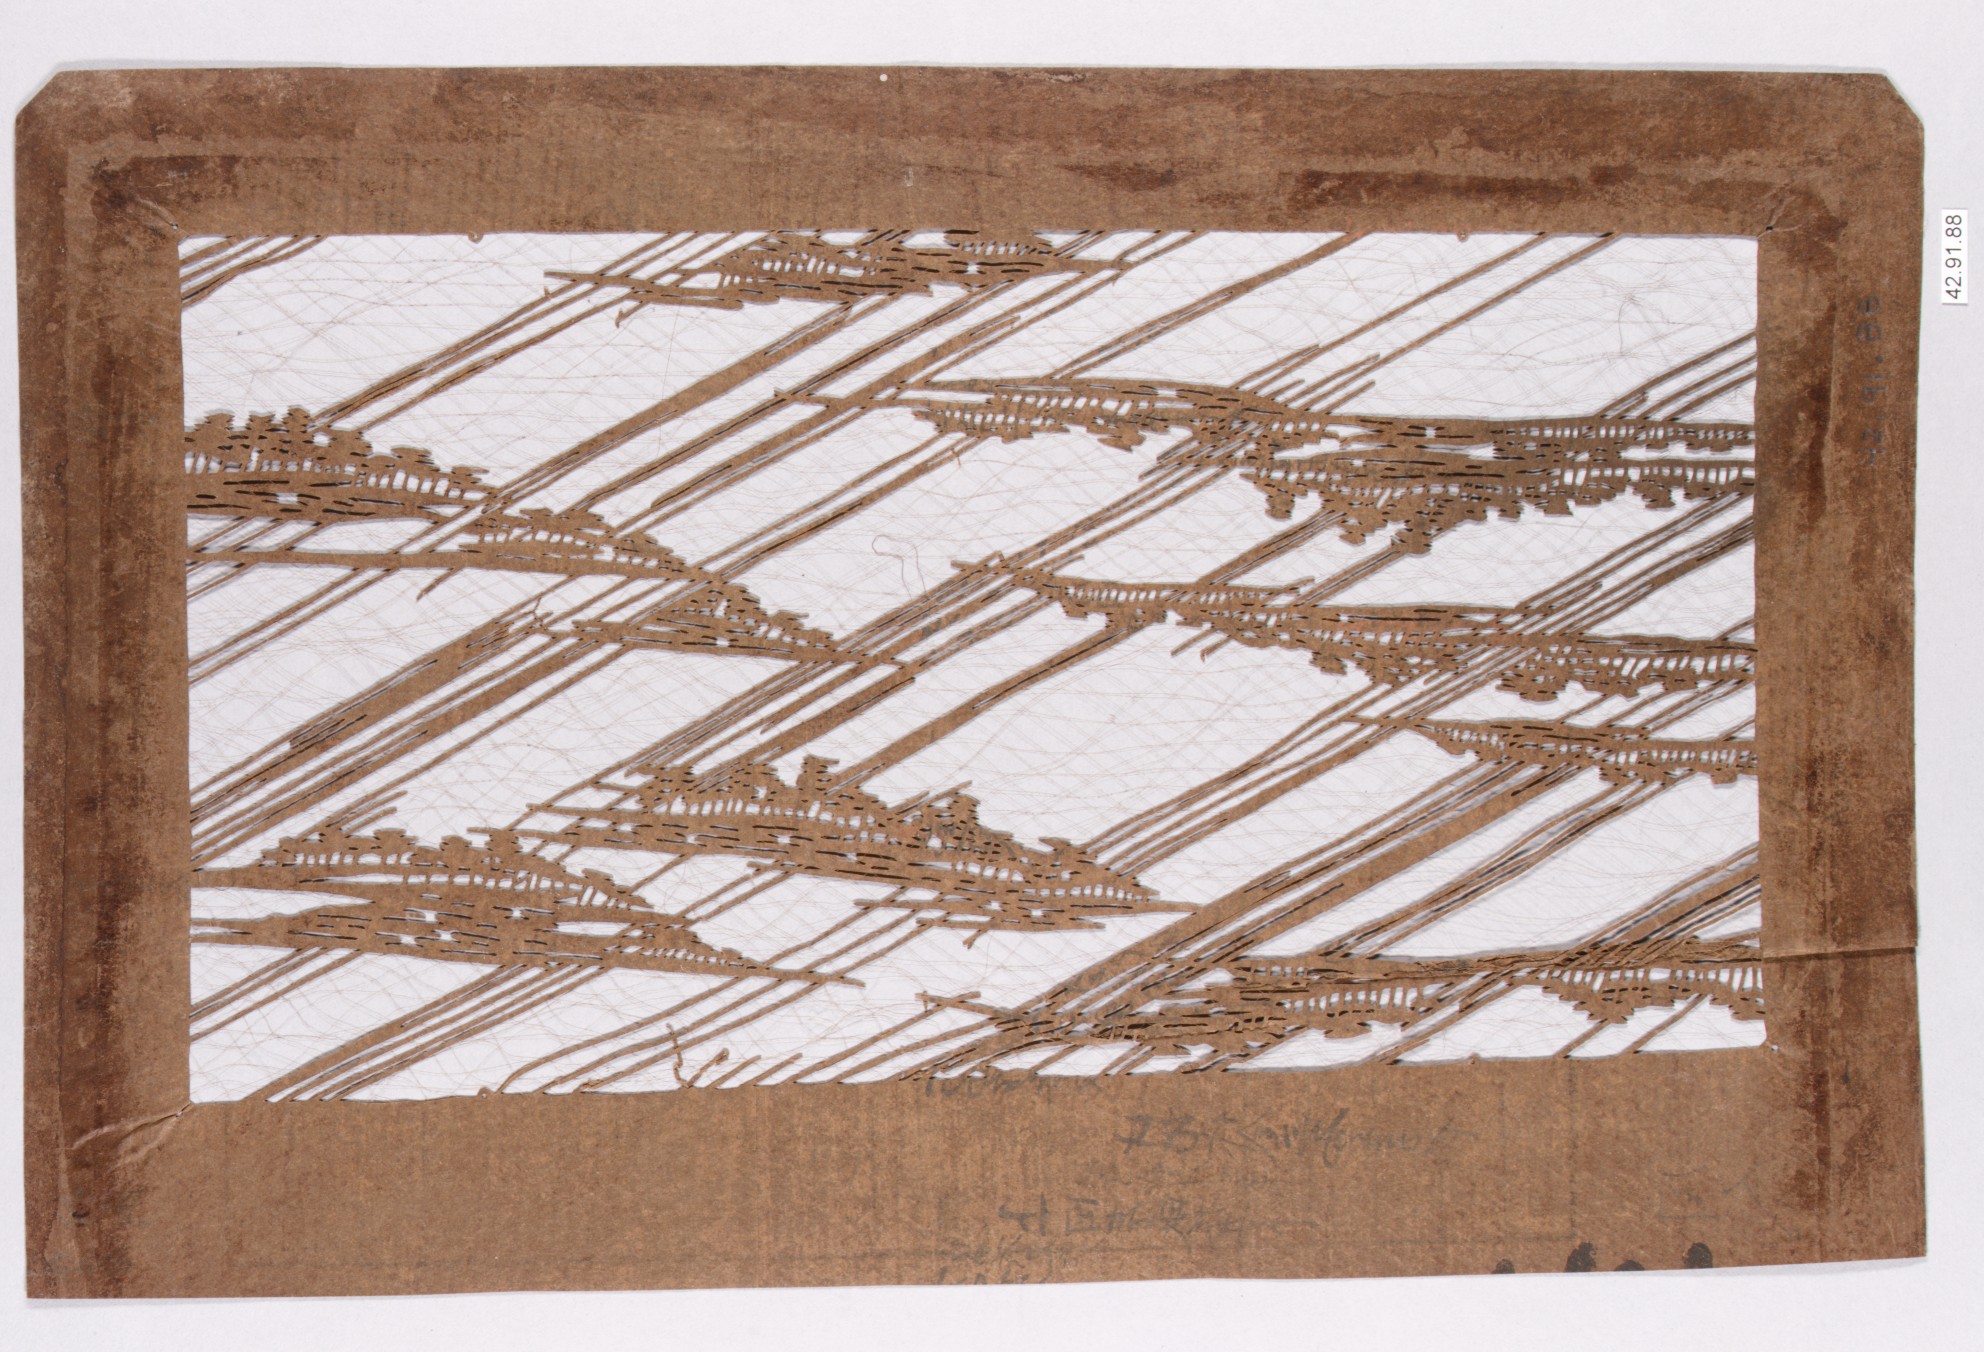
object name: stencil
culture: japanese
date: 1801-1900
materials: paper, silk